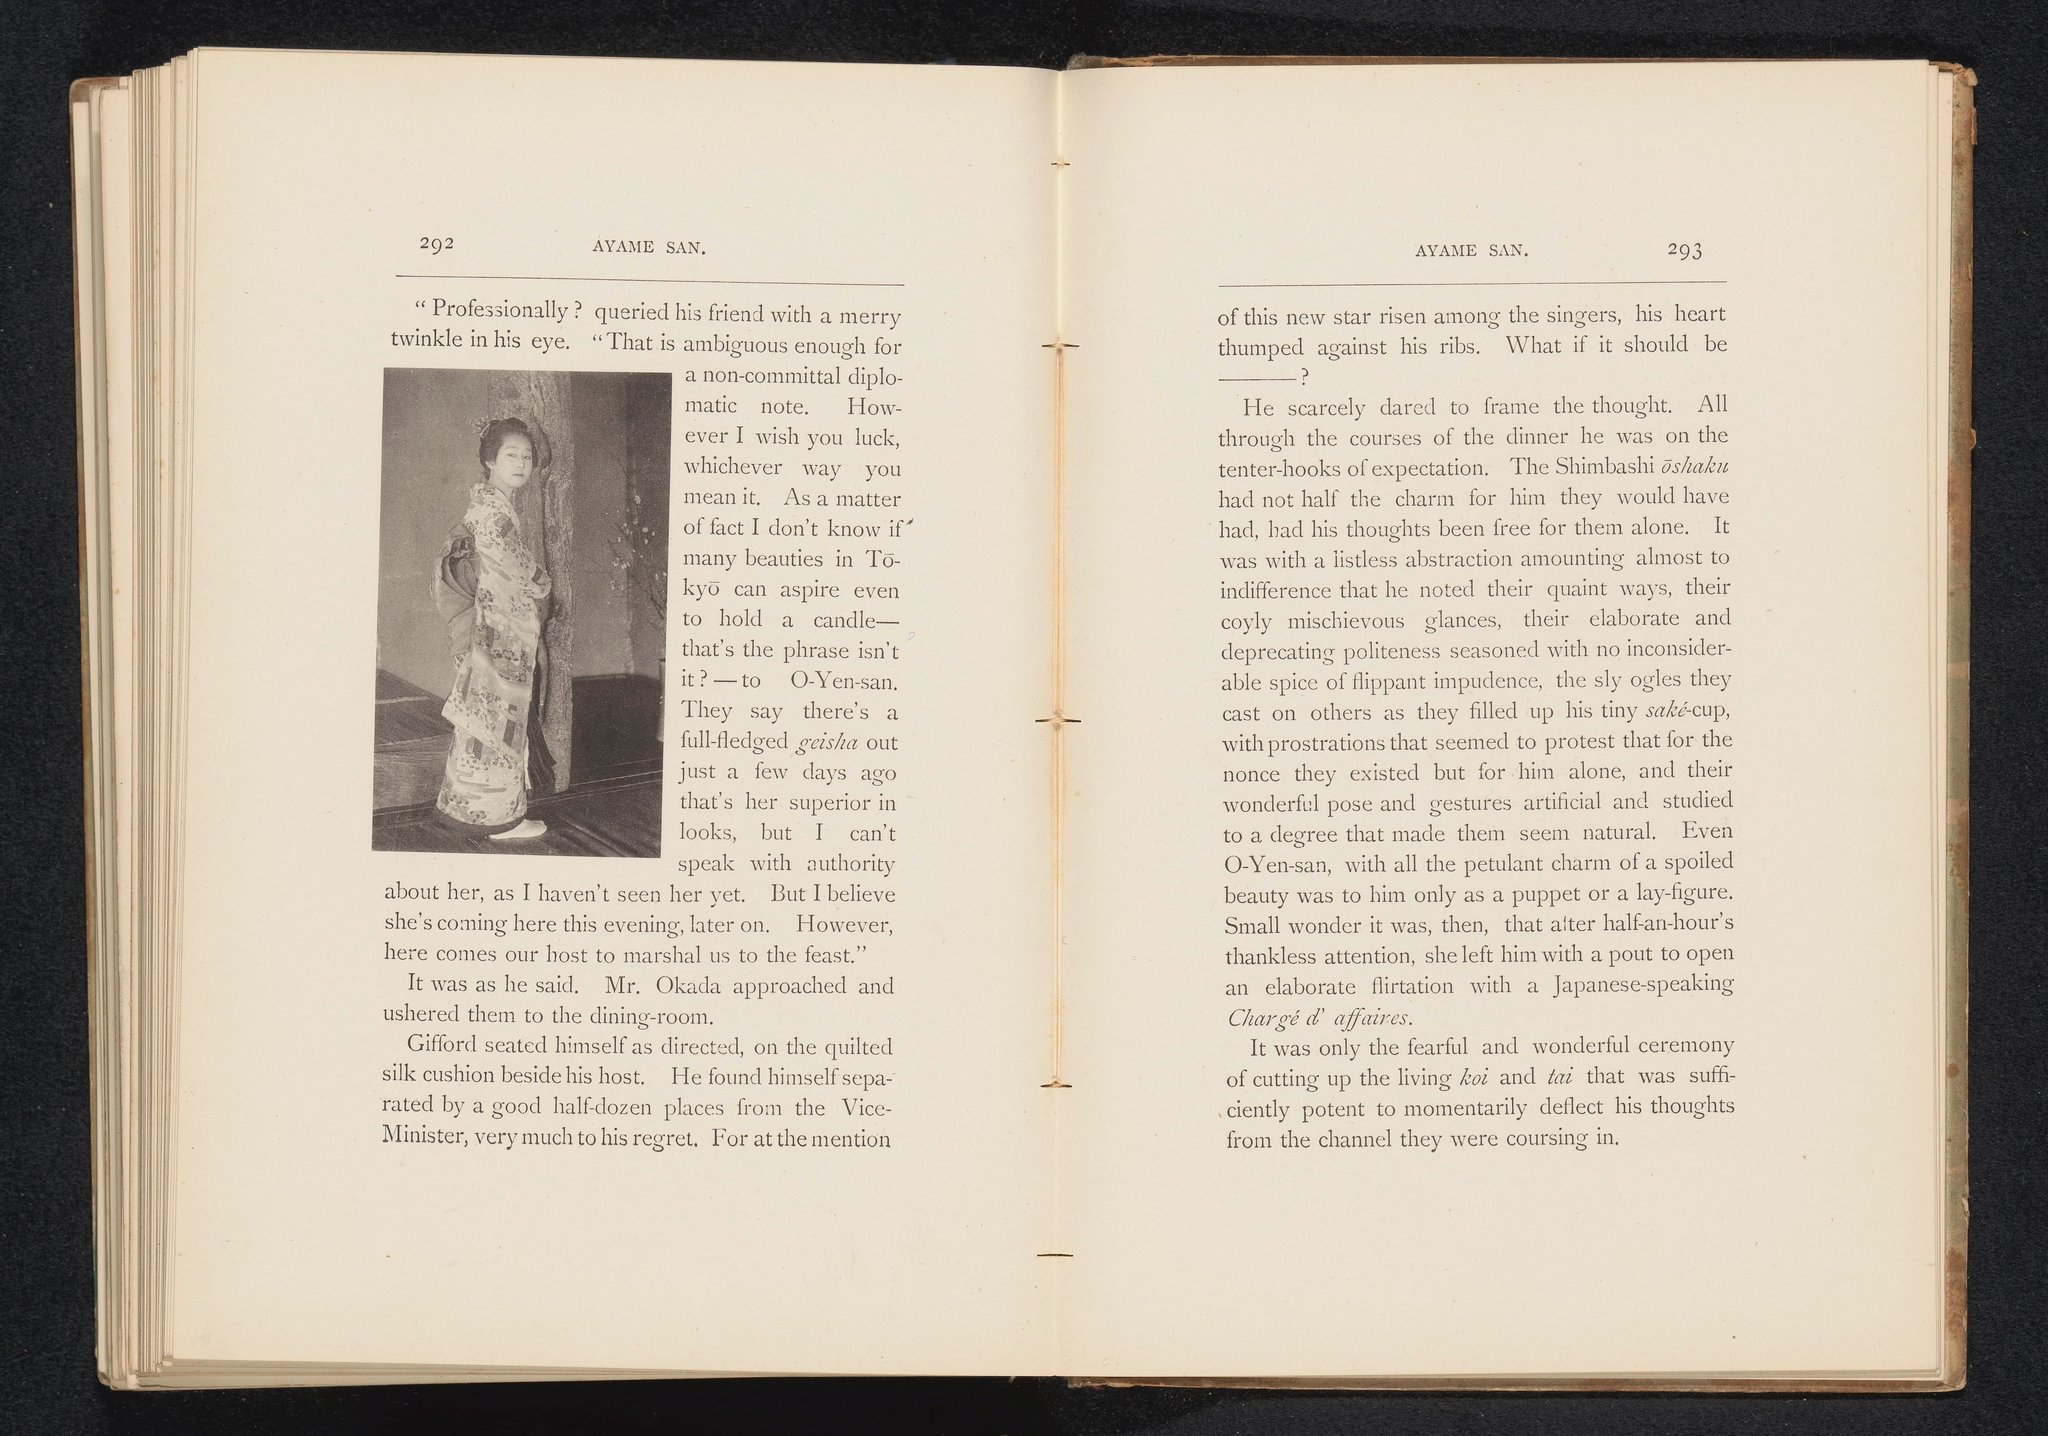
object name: page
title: Vrouw in een kimono naast een houten pilaar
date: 1882-1892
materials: paper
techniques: photograph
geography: japan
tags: adult woman, column, pillar ~ architecture, dress, gown